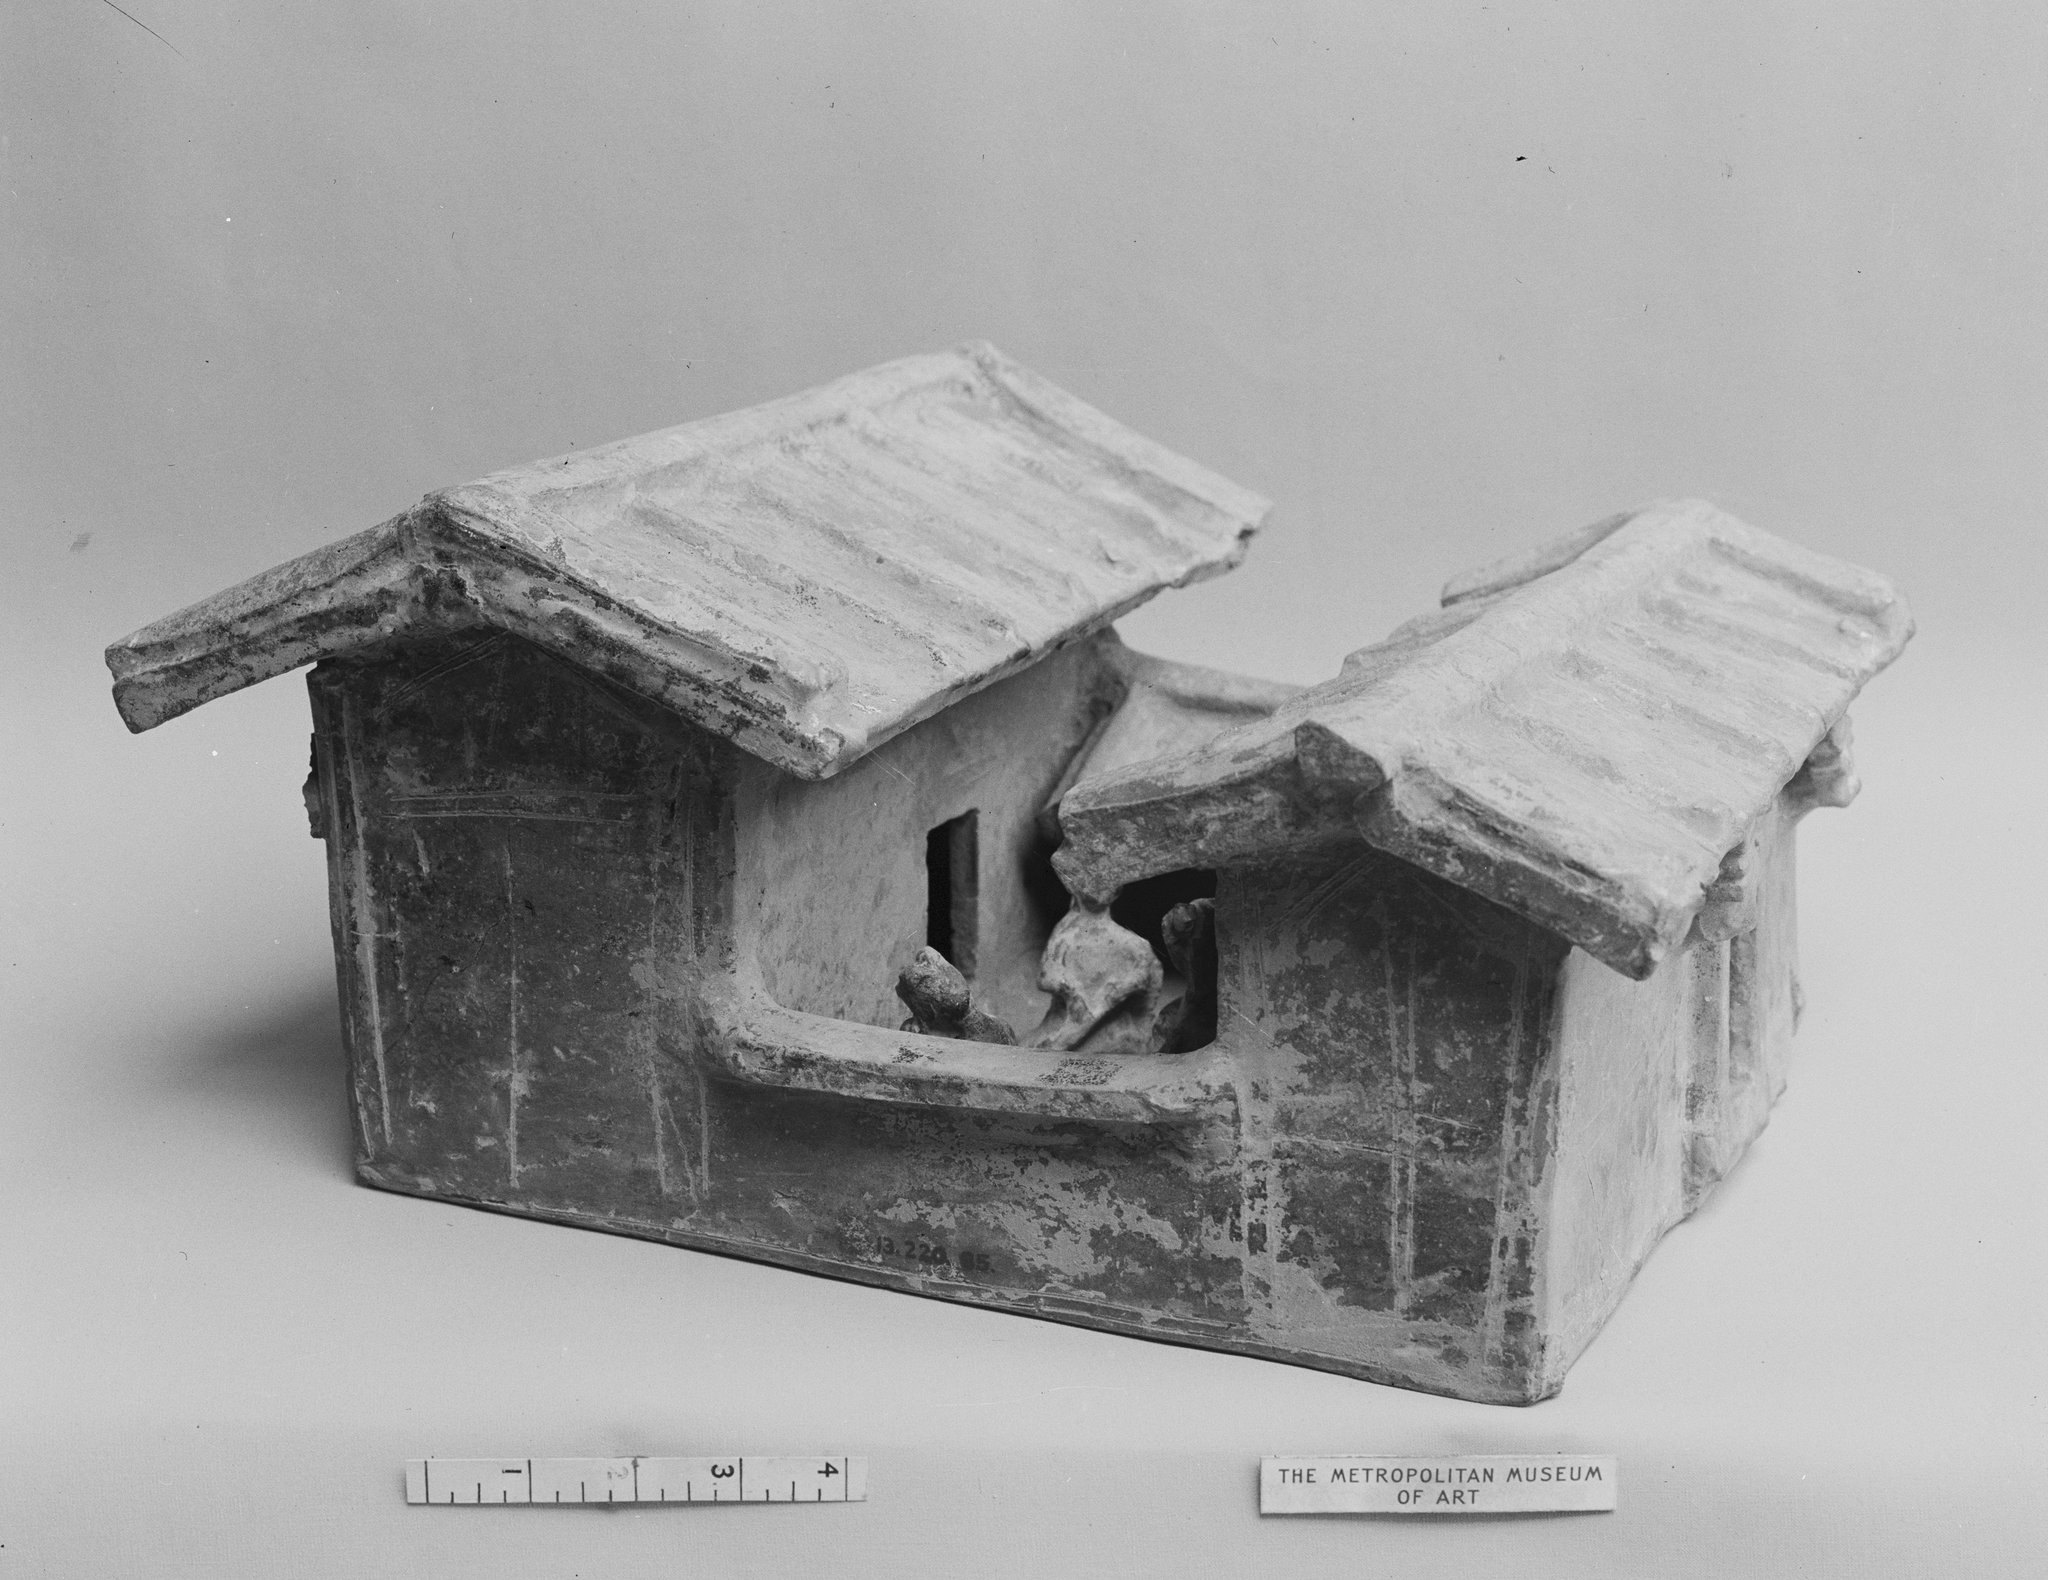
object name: model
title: House with Courtyard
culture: chinese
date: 1-233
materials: earthenware, glaze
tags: human figures,houses,courtyards